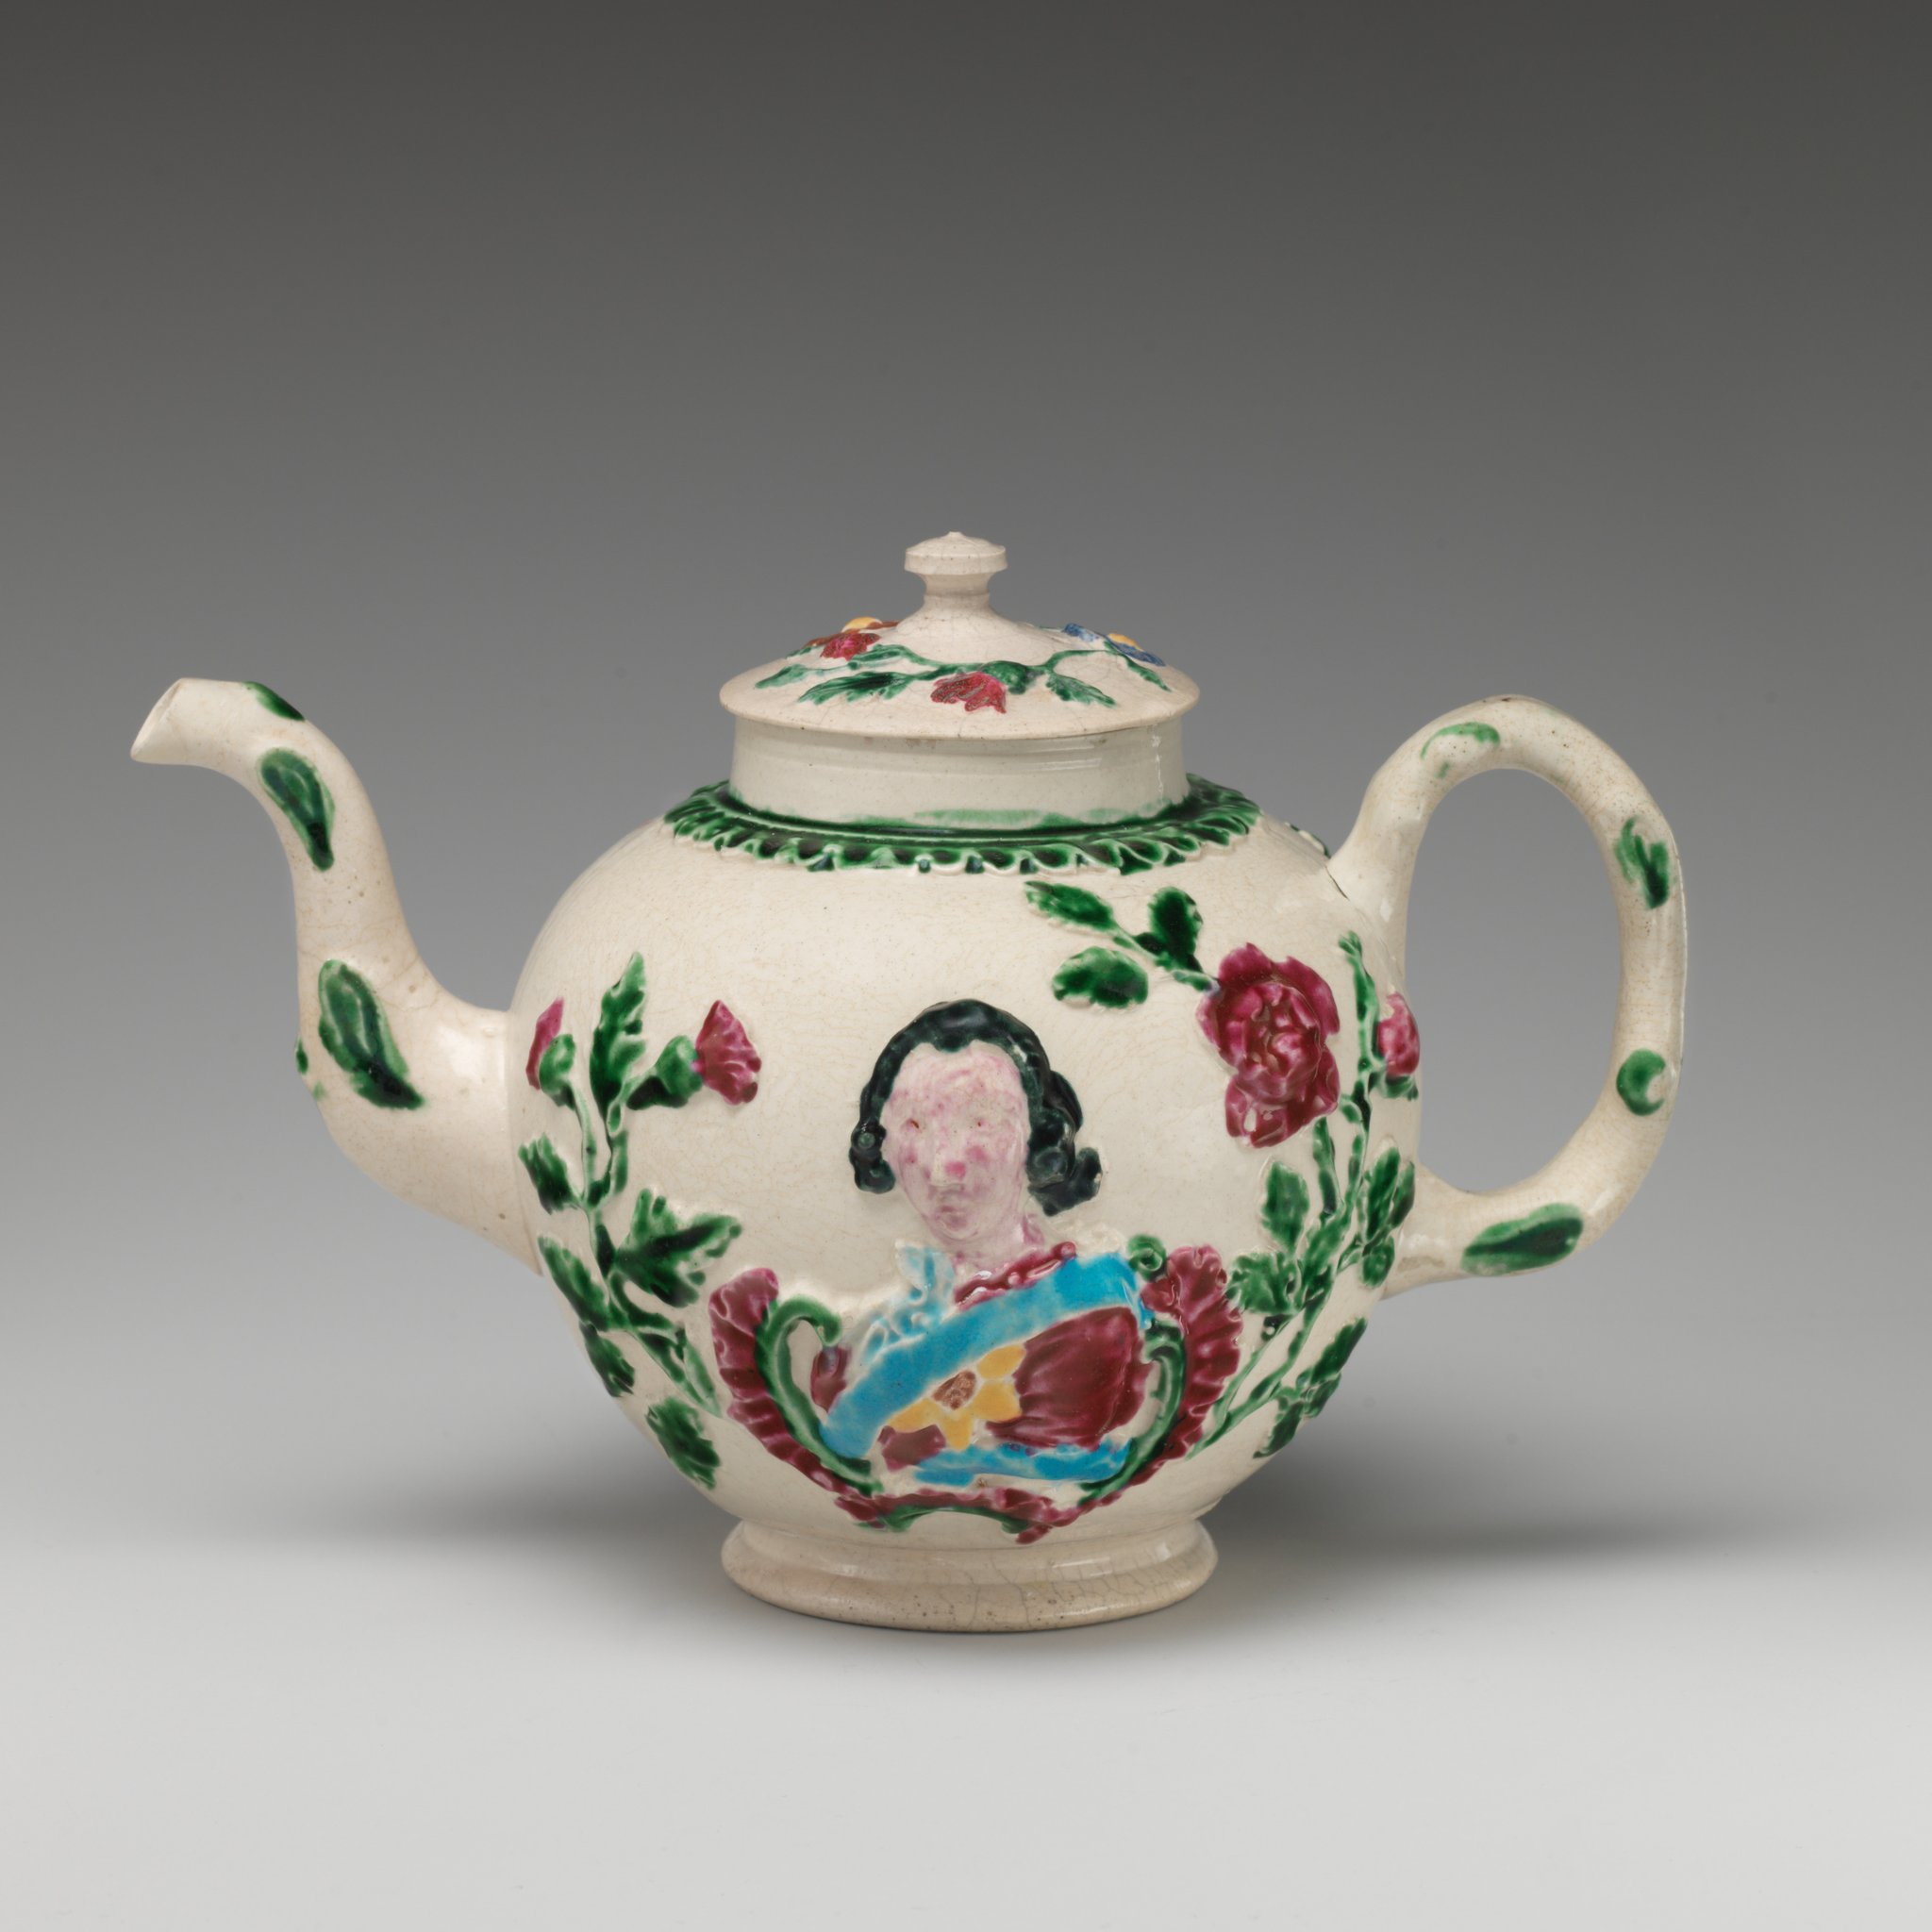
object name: teapot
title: Teapot with portrait of the Young Pretender, Prince Charles Edward Stuart (1720–1788)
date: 1765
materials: enamel, stoneware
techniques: salt glaze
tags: flowers